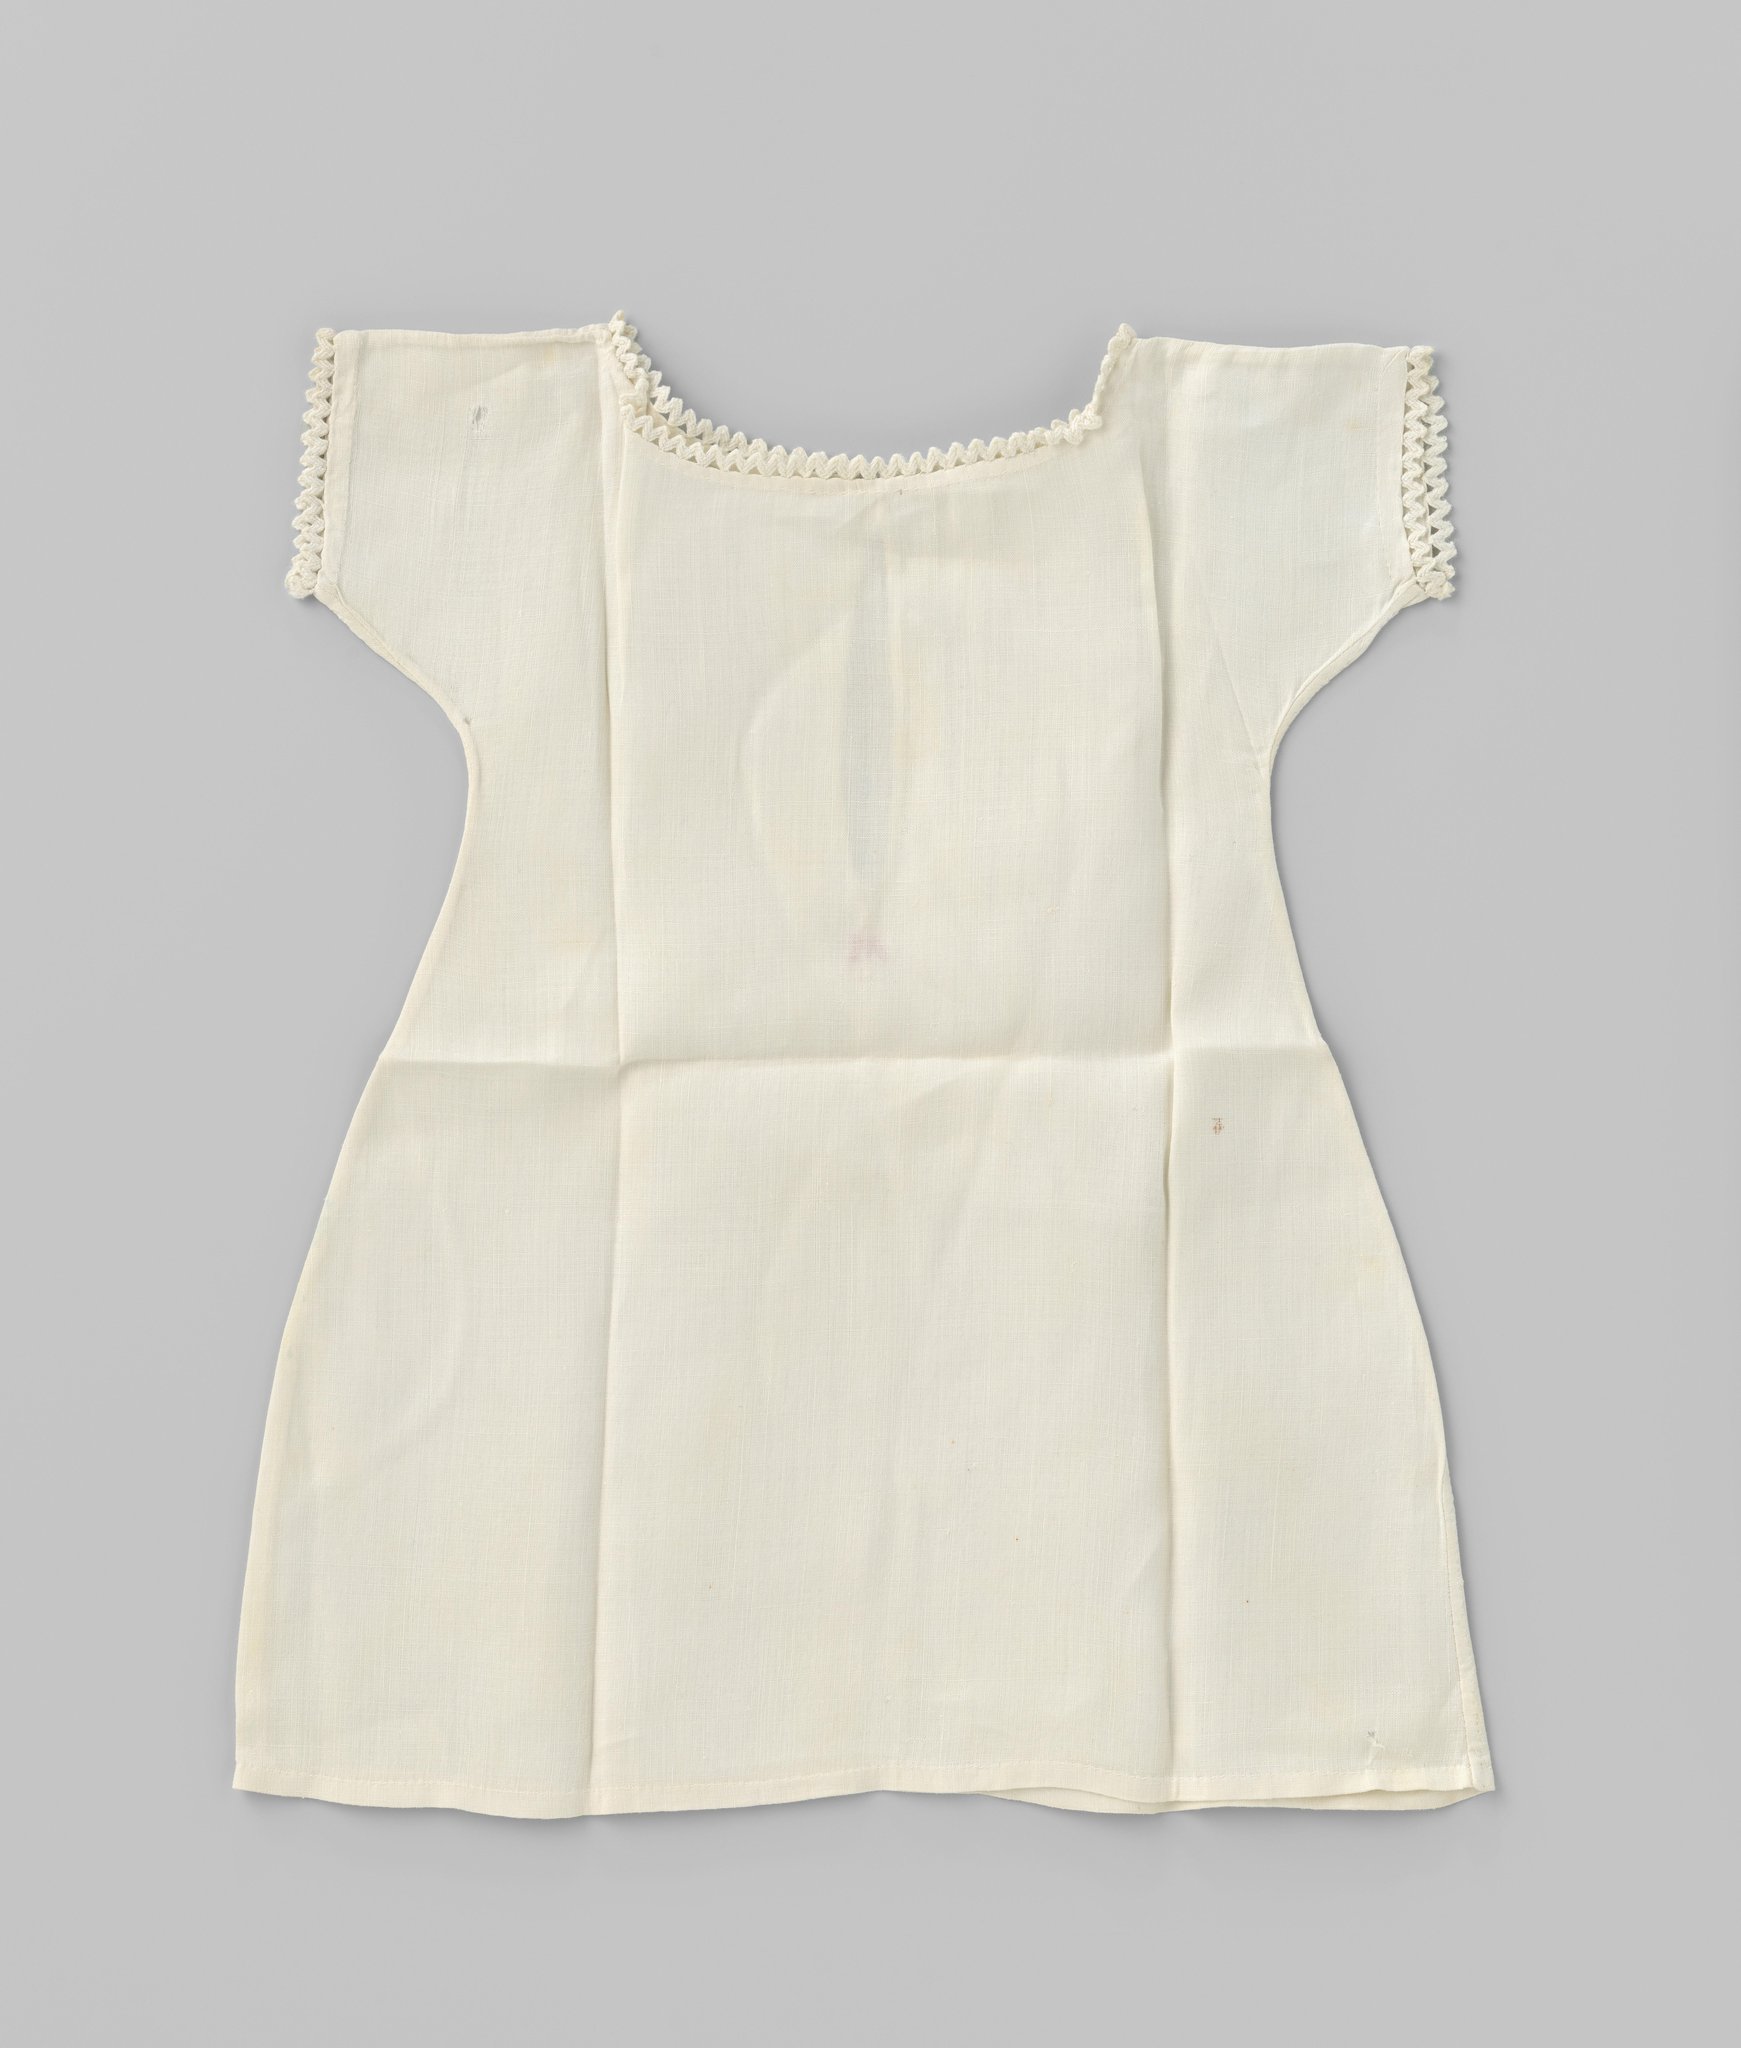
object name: toy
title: Hemd met korte mouwen afgebiesd met zigzagband voor pop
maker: Anonymous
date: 1850-1920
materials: textile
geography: netherlands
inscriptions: inscription: ‘M’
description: Langs de hals en aan het uiteinde van de mouwen is het witte hemd afgebiesd met zigzagband. Aan de achterzijde sluit het hemd met een witte knoop.